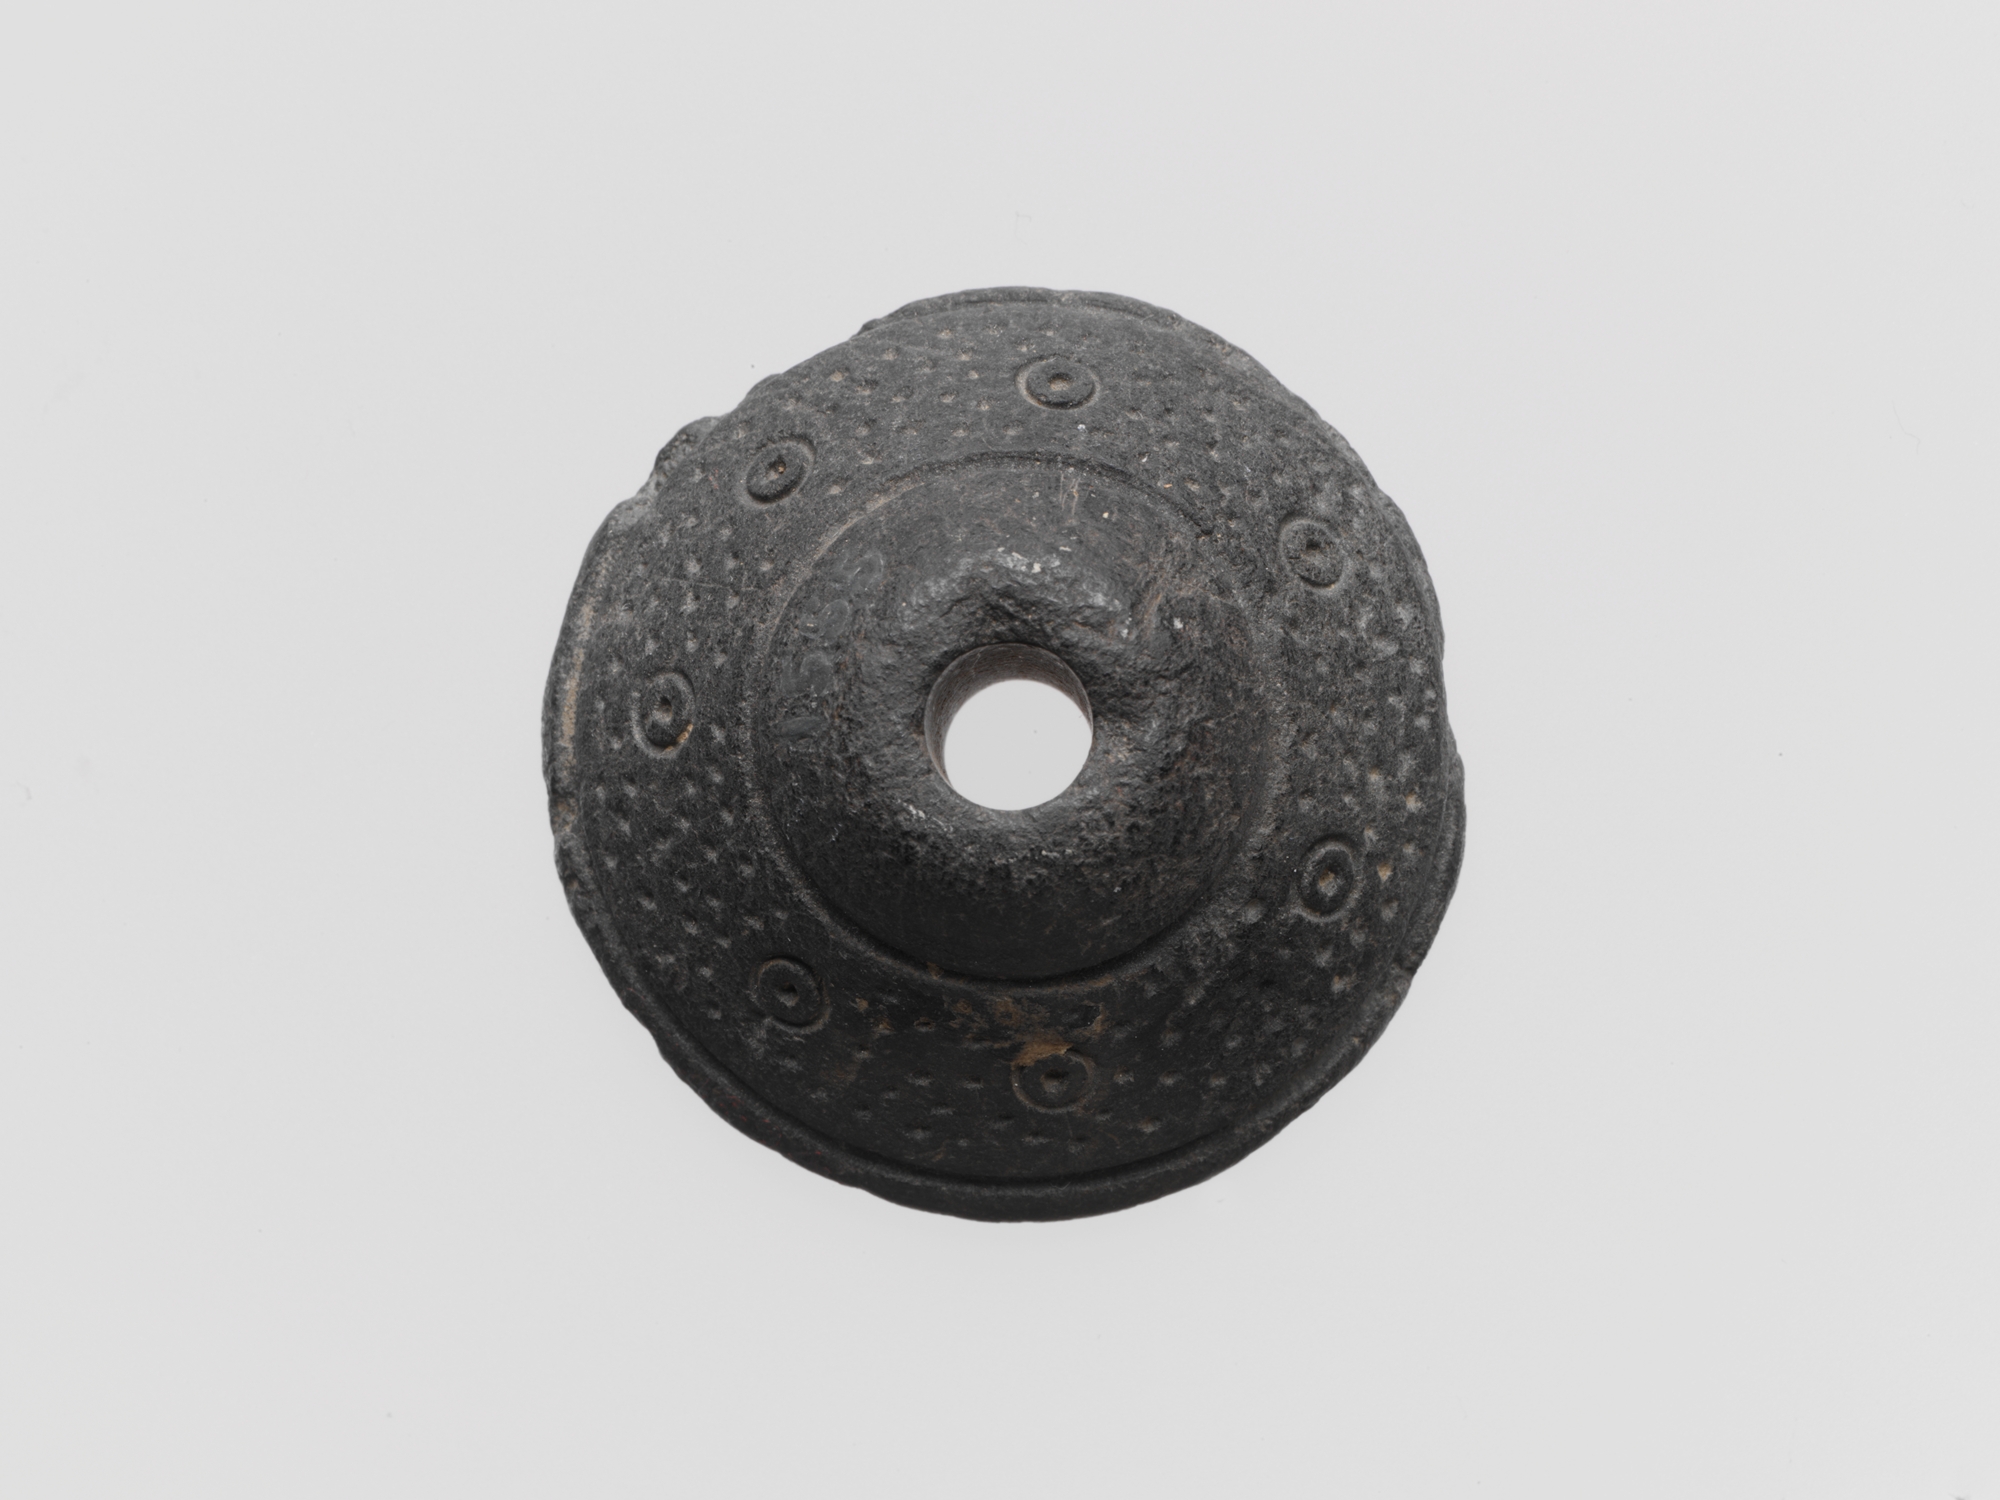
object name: spindle whorl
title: Chlorite spindle whorl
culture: cypriot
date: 1200-1050 BCE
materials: mineral